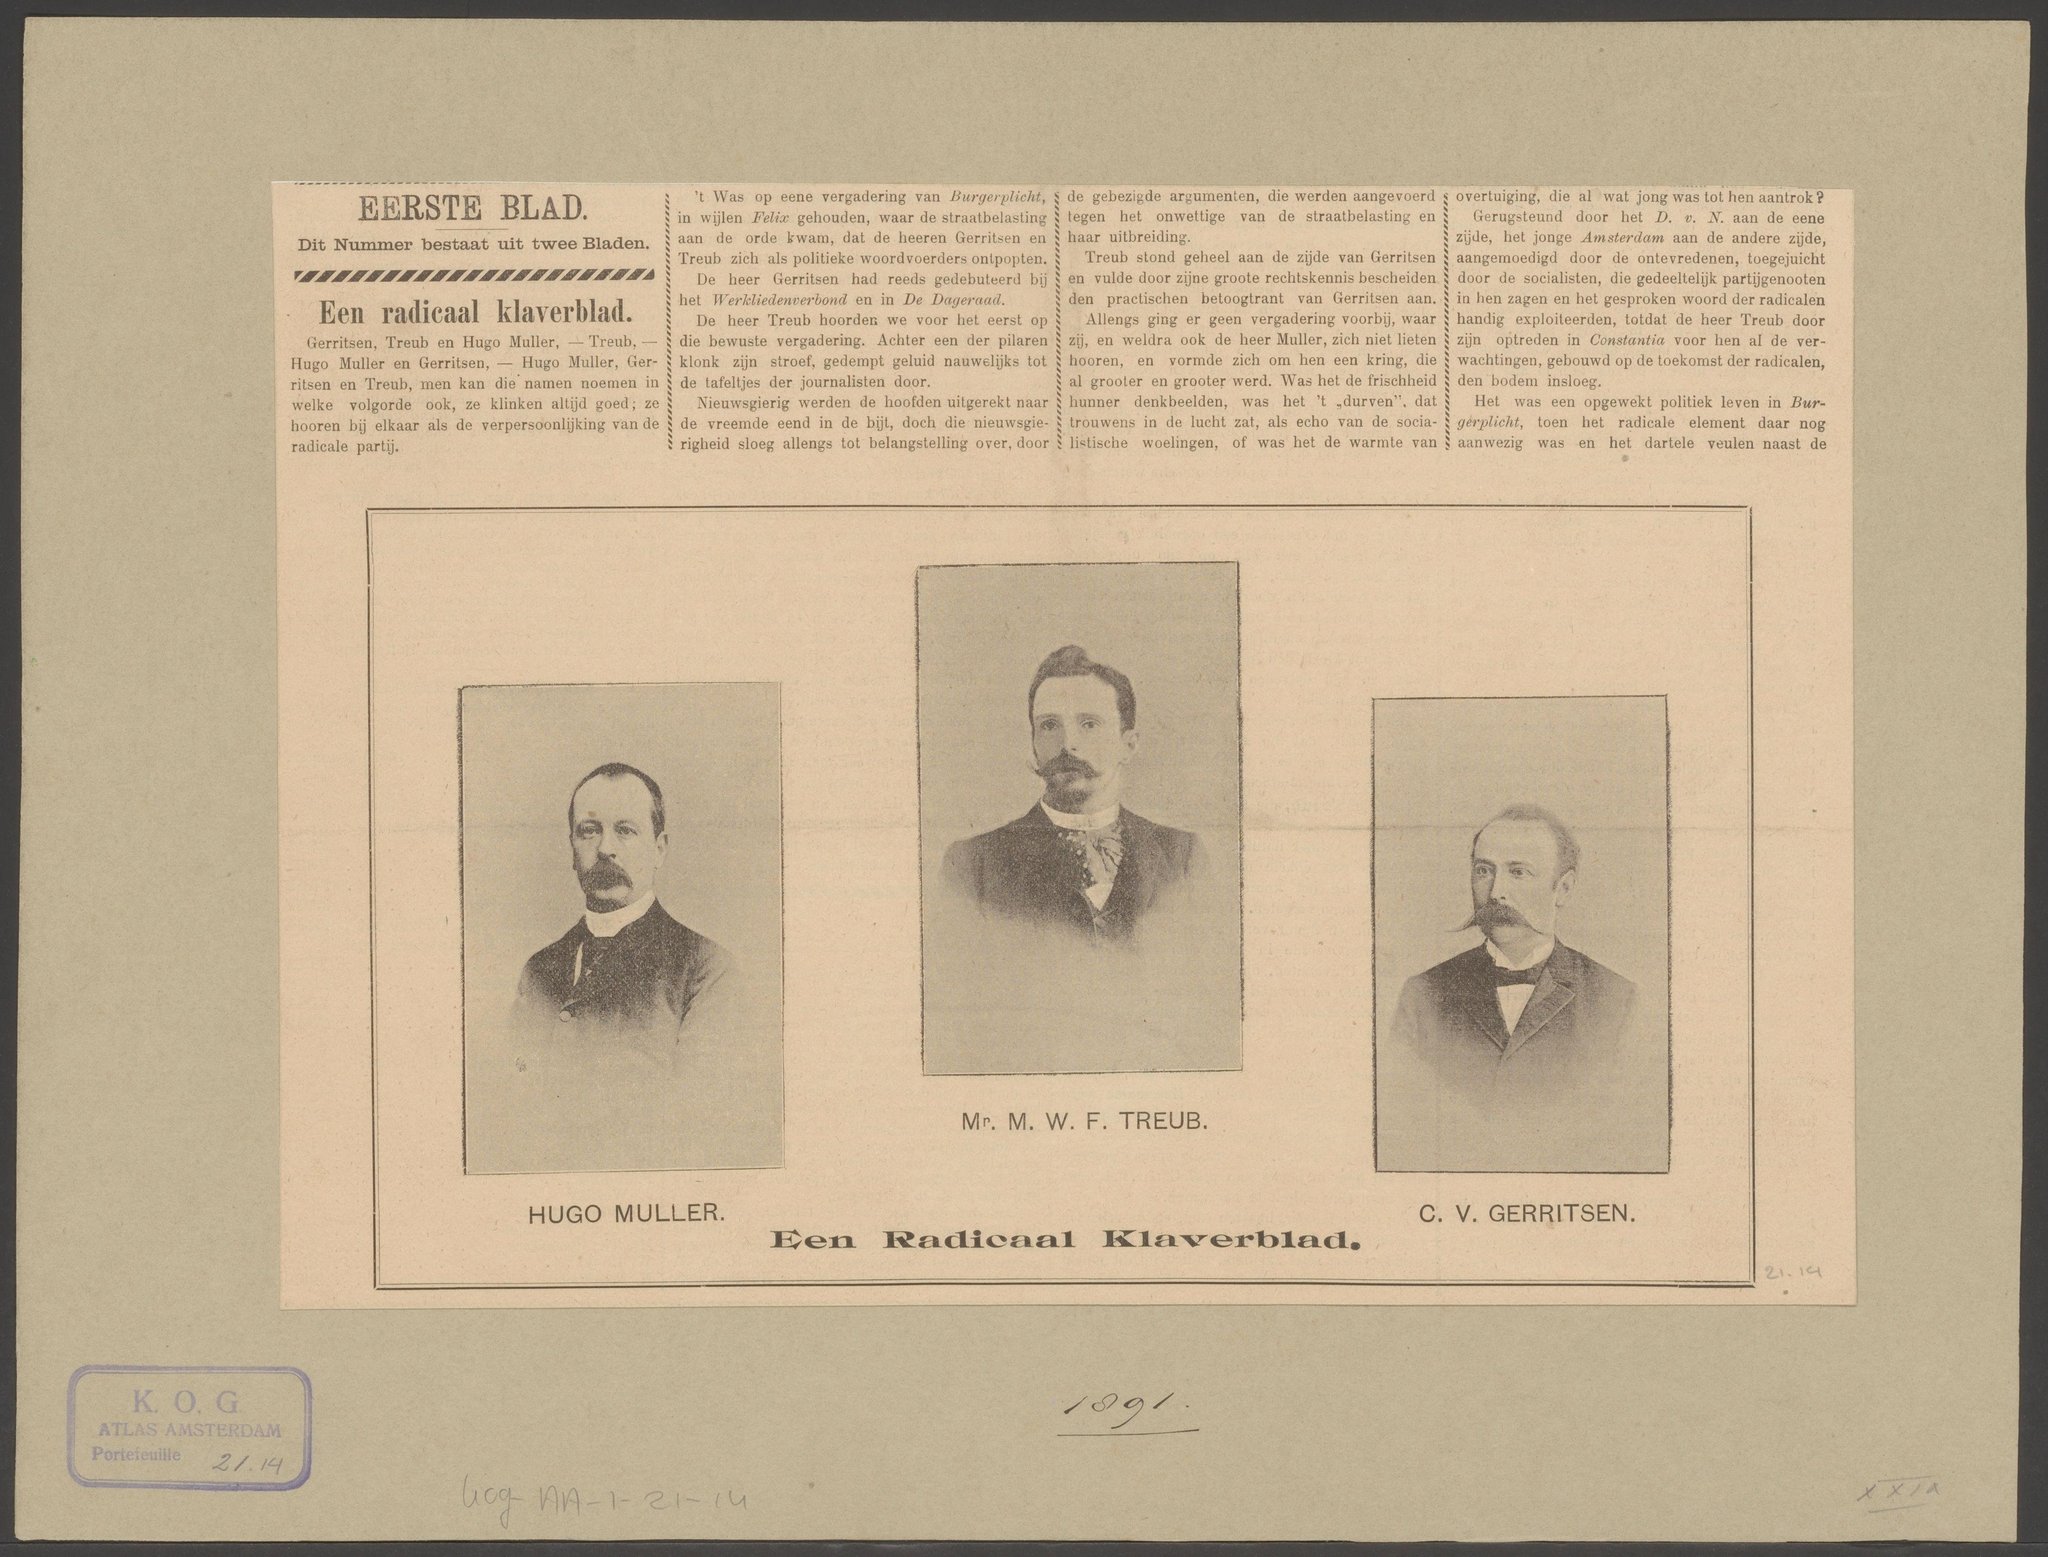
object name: photomechanical print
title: Een Radicaal Klaverblad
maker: Anonymous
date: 1891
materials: paper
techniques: letterpress printing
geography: netherlands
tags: voorschoten, the hague, politician, historical persons, politician, e.g. party leader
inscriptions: collector's mark: Lugt 1641b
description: Onderwerpsrubriek binnen de Atlas Amsterdam: Kiesverenigingen, Politieke partijen.